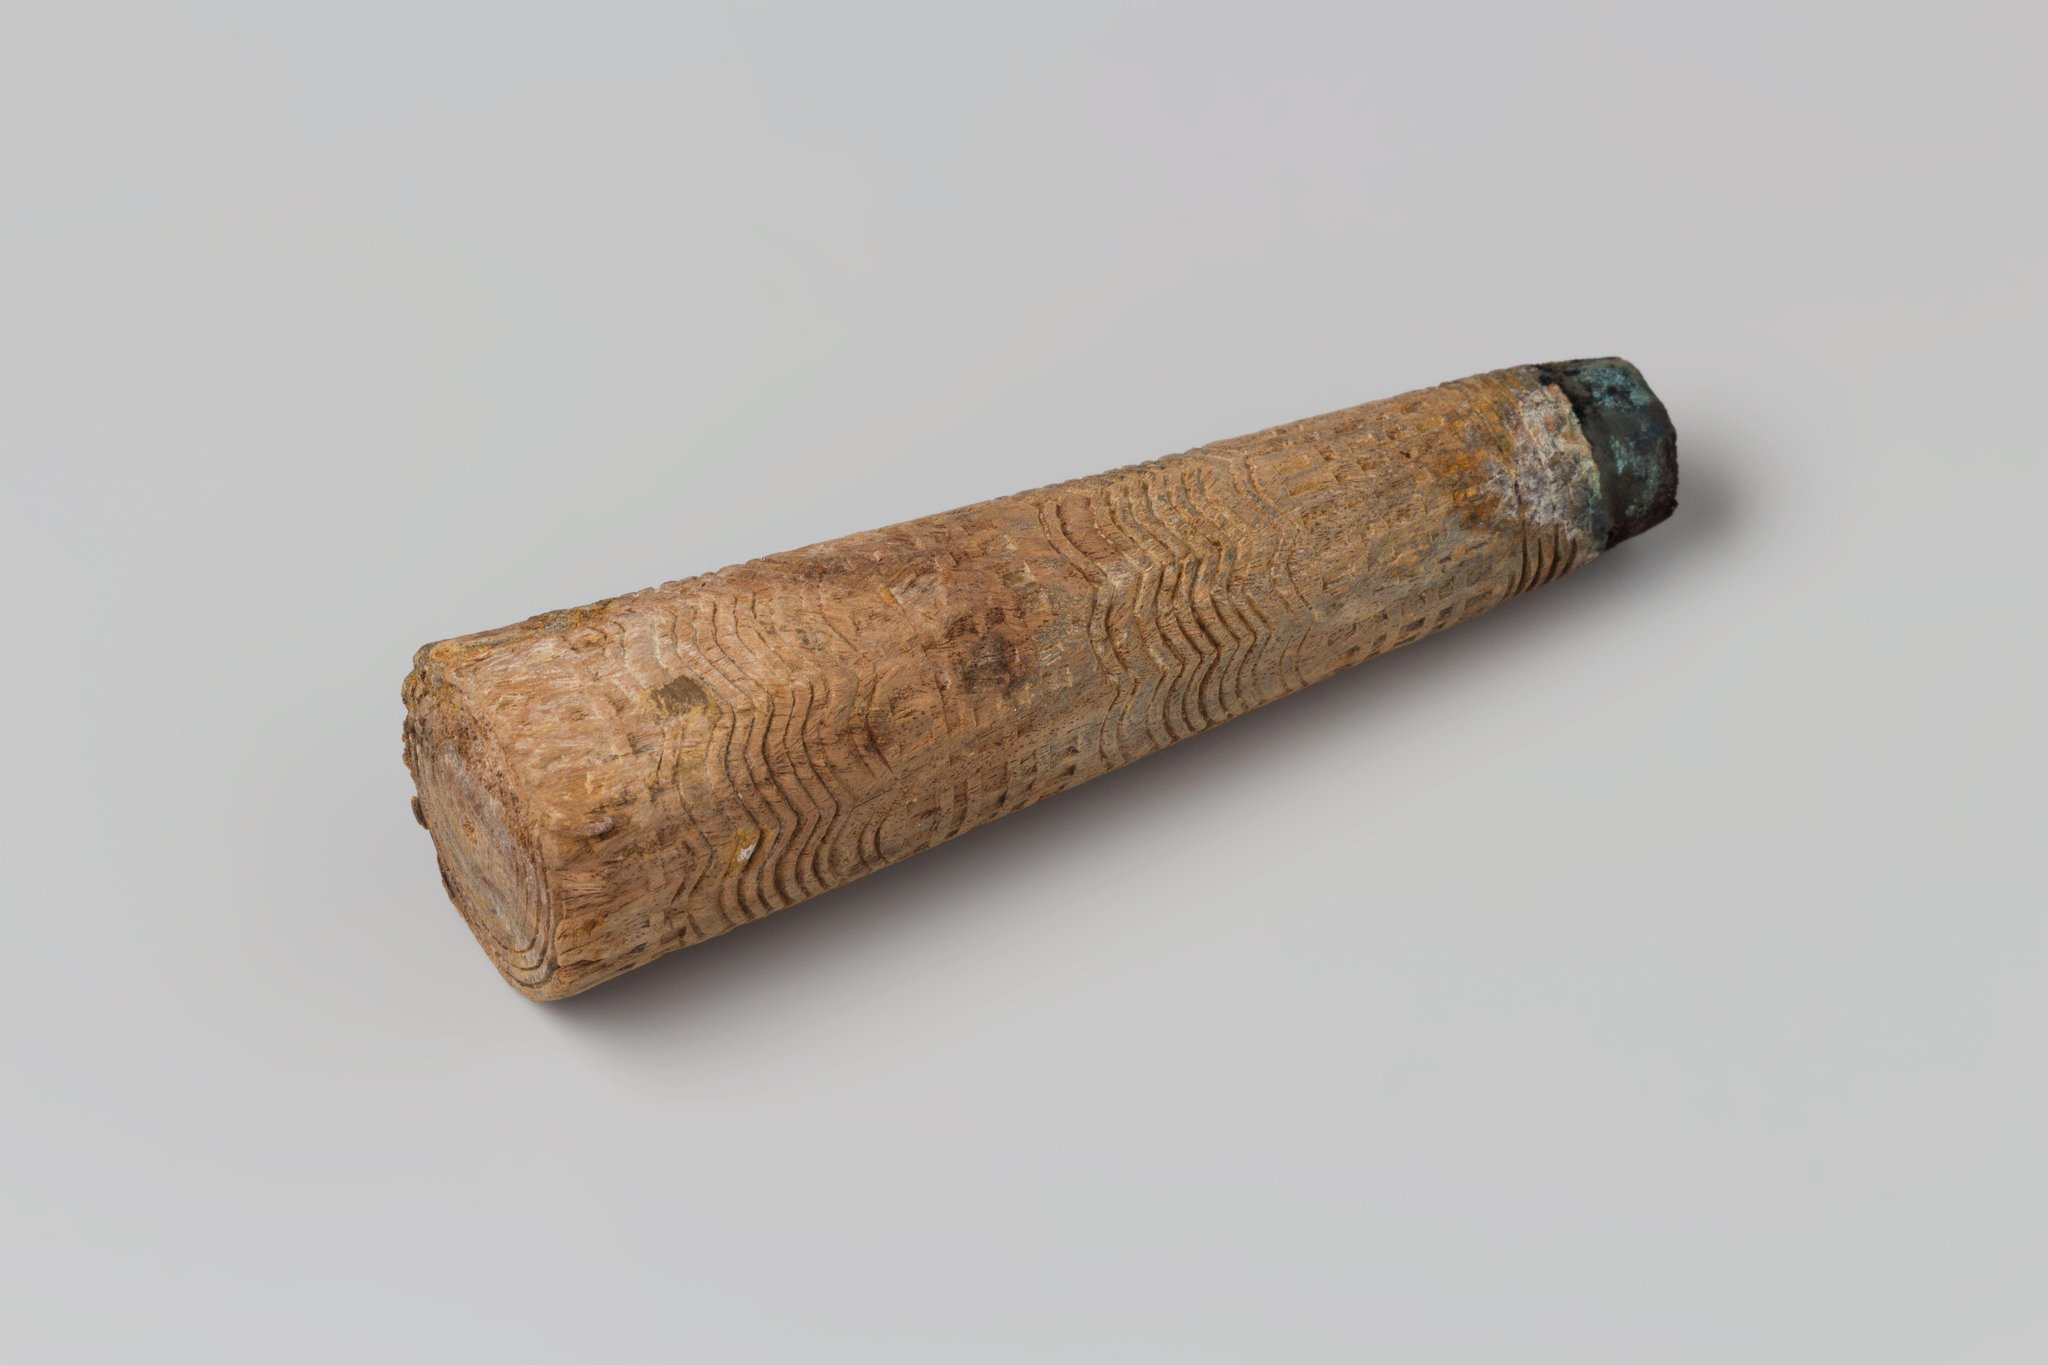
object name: knife handle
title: Messenheft uit het wrak van de Oost-Indiëvaarder Hollandia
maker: Anonymous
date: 1700-1743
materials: copper, wood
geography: netherlands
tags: verenigde oostindische compagnie, hollandia (schip), annet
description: Knife, handle, cylindrical: tapering; id. NG 1979-403H, ferrule, id. NG 1980-27H426.